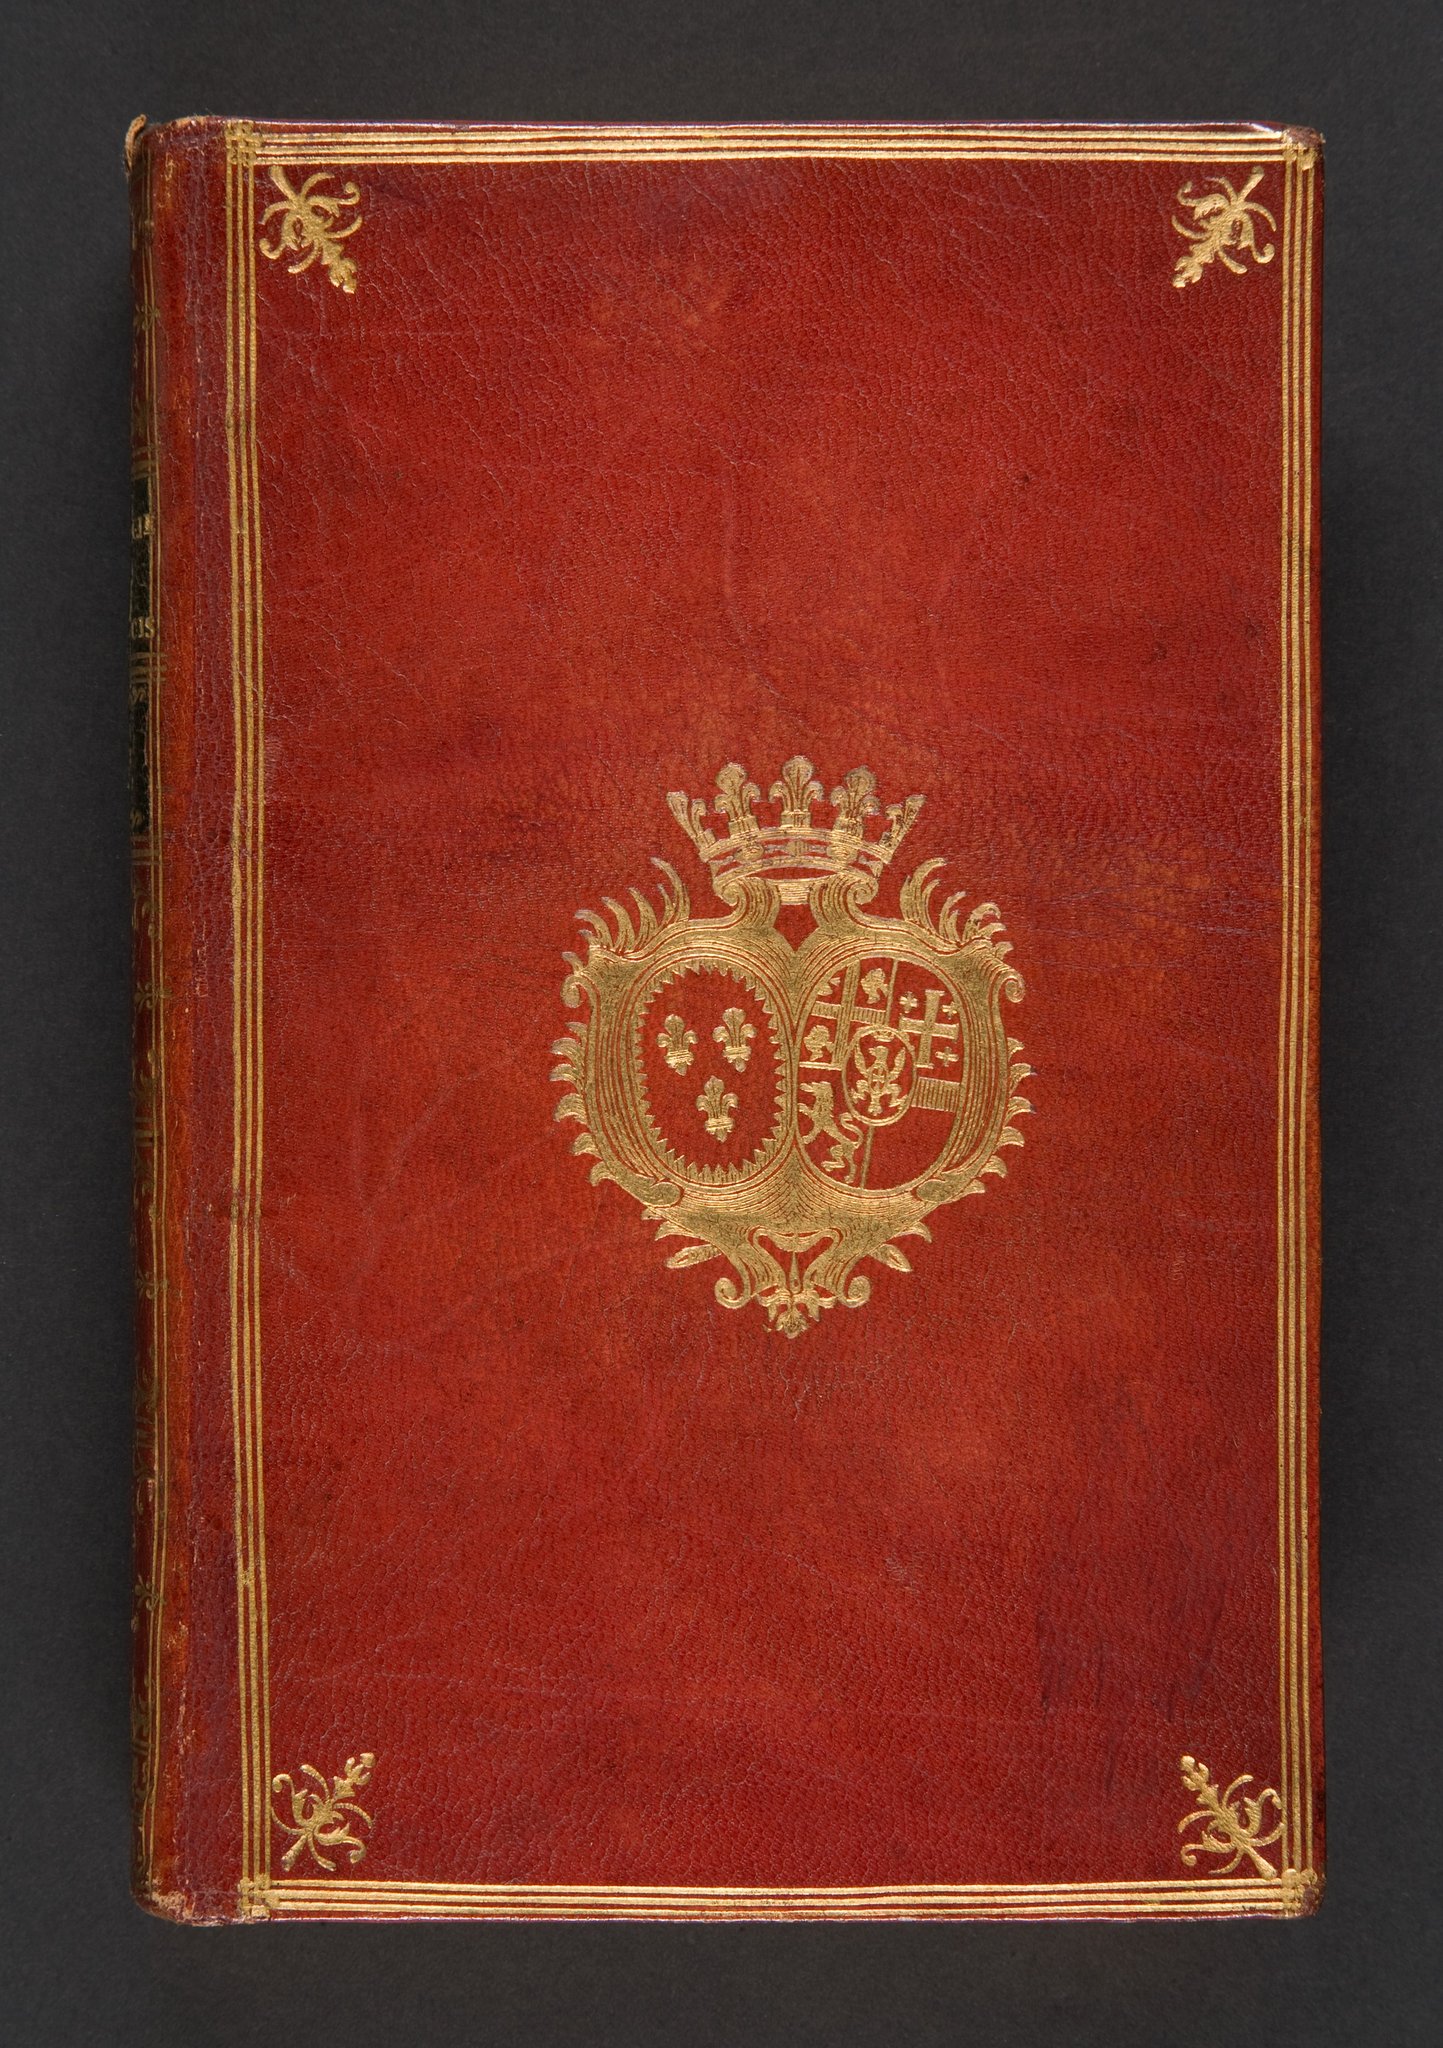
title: Anthologie françoise, ou, Chansons choisies, depuis le 13a siècle jusqu'à présent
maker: jean monnet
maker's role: author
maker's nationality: french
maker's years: 1703-1785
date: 1765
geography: france